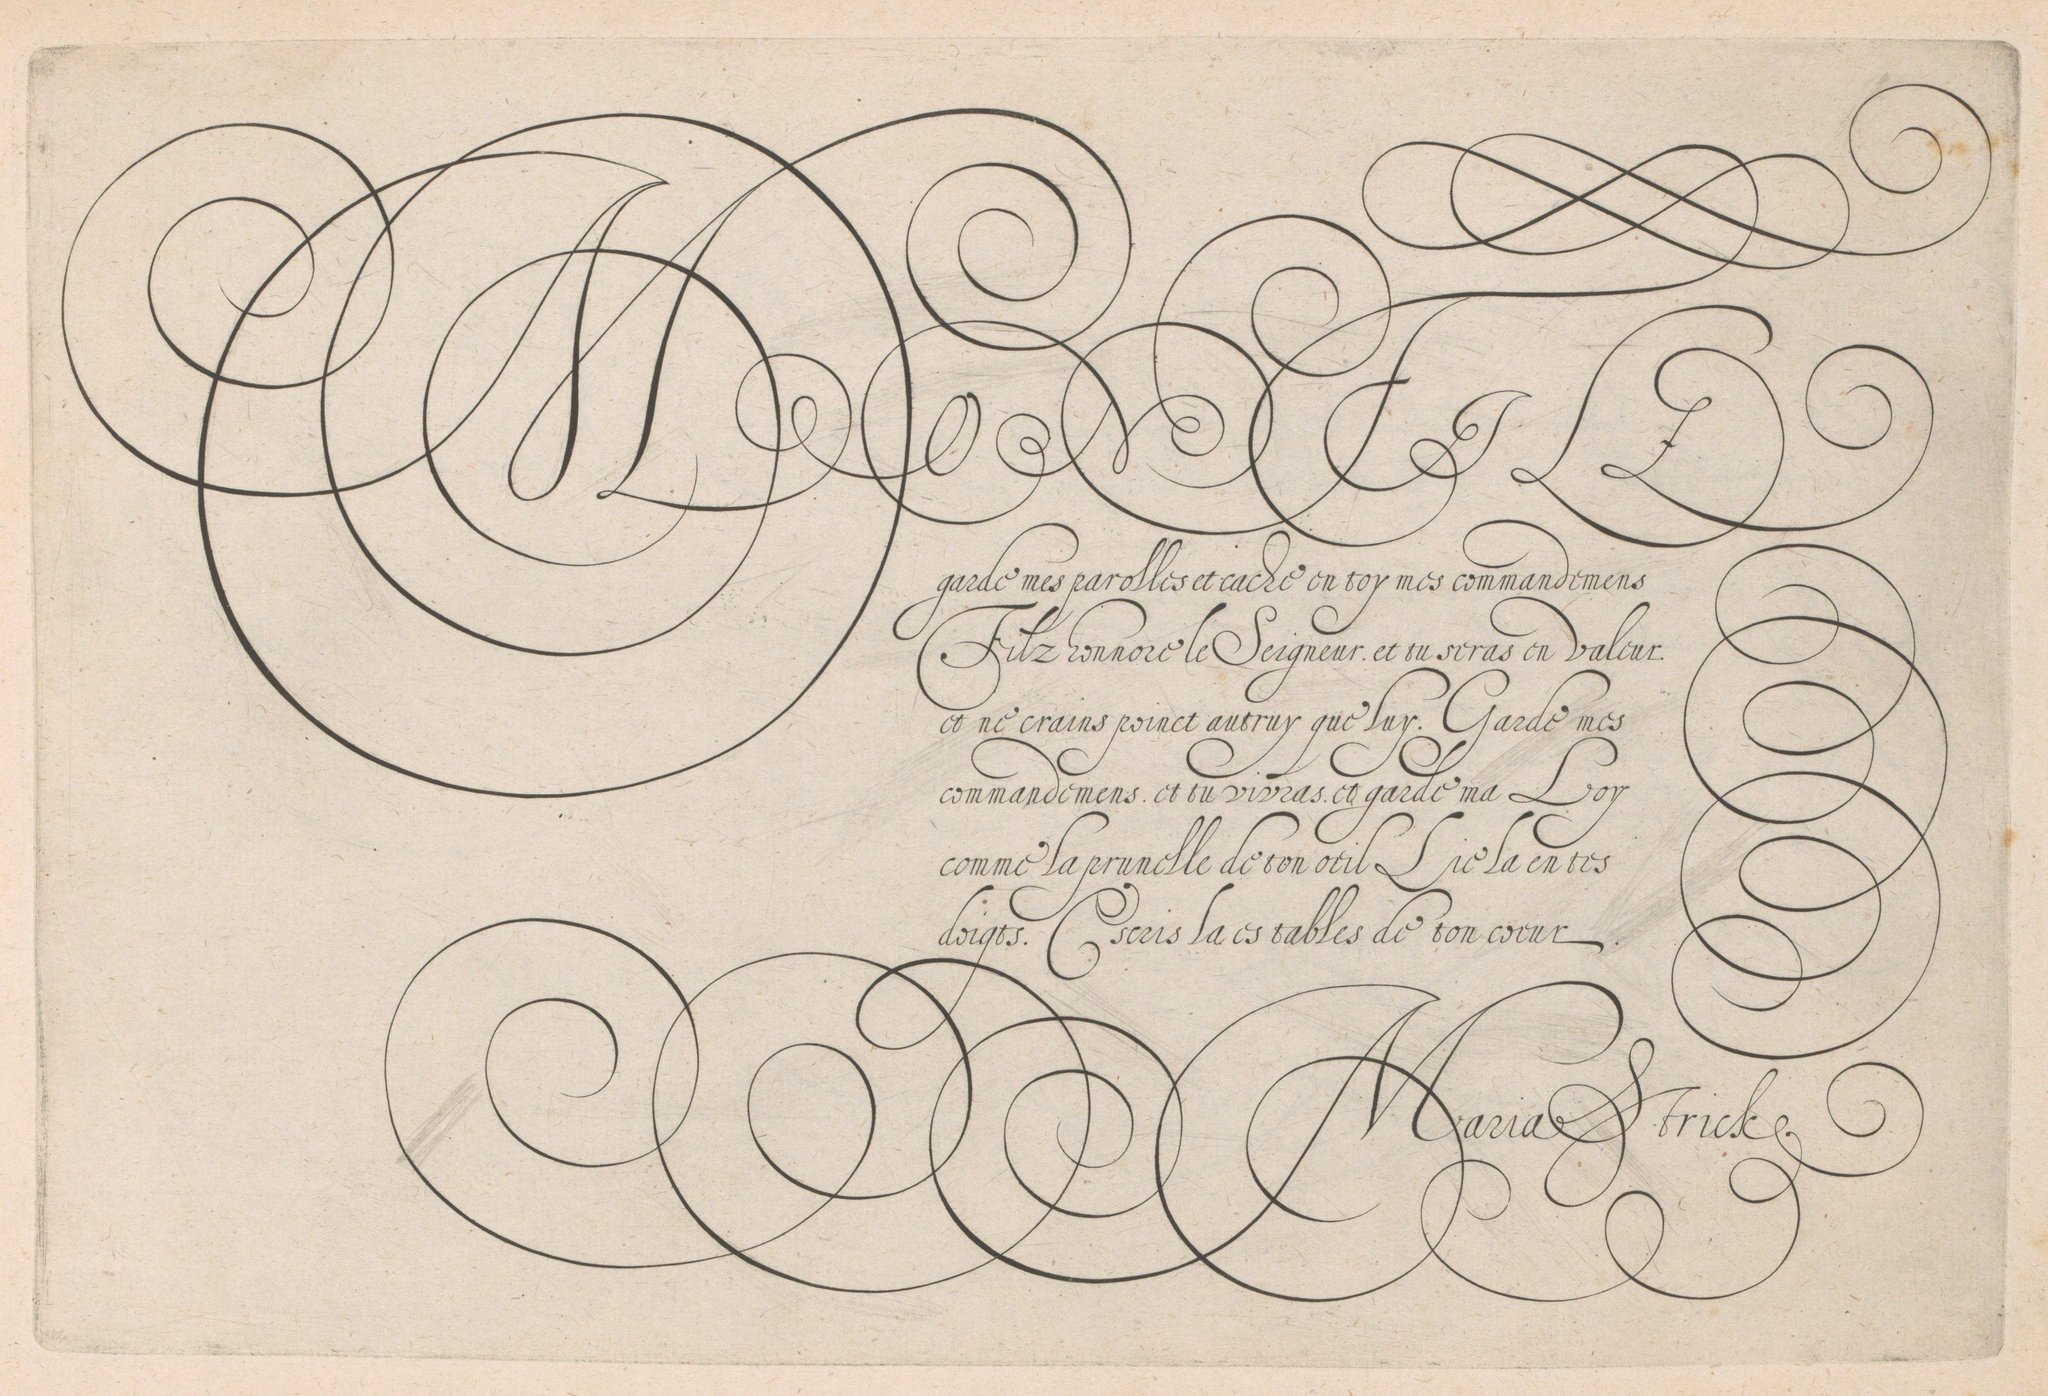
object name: ornament print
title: Schat oft voorbeelt ende verthooninge van verscheyden geschriften (...)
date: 1618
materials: paper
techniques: engraving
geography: rotterdam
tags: calligraphy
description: Schrijfvoorbeeld in het Frans met kapitaal M en zeven regels tekst: Mon fils (...). Omlijst door kalligrafisch krulwerk. De prent maakt deel uit van een album.